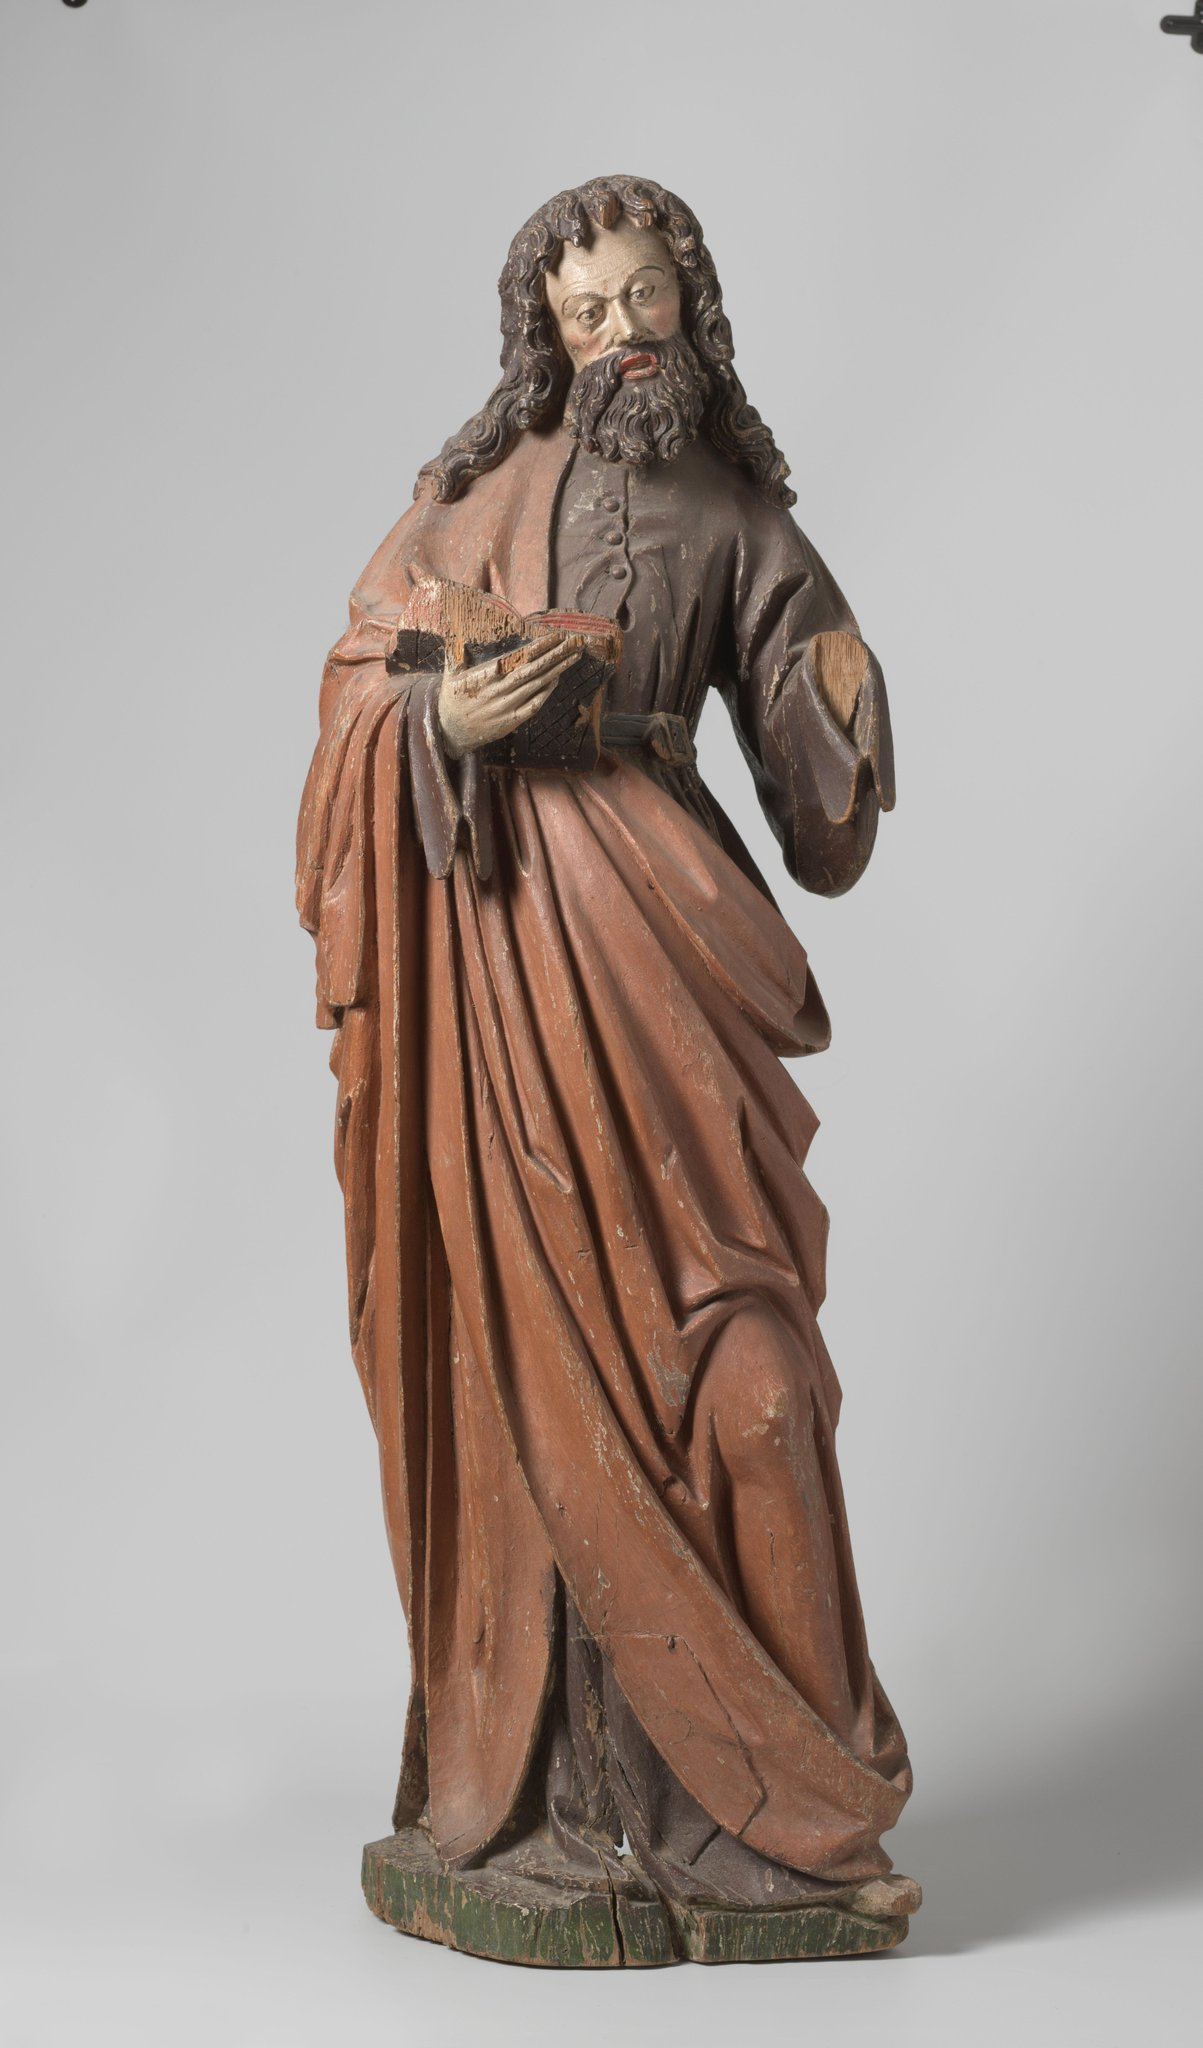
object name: sculpture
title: Evangelist or Apostle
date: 1520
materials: wood